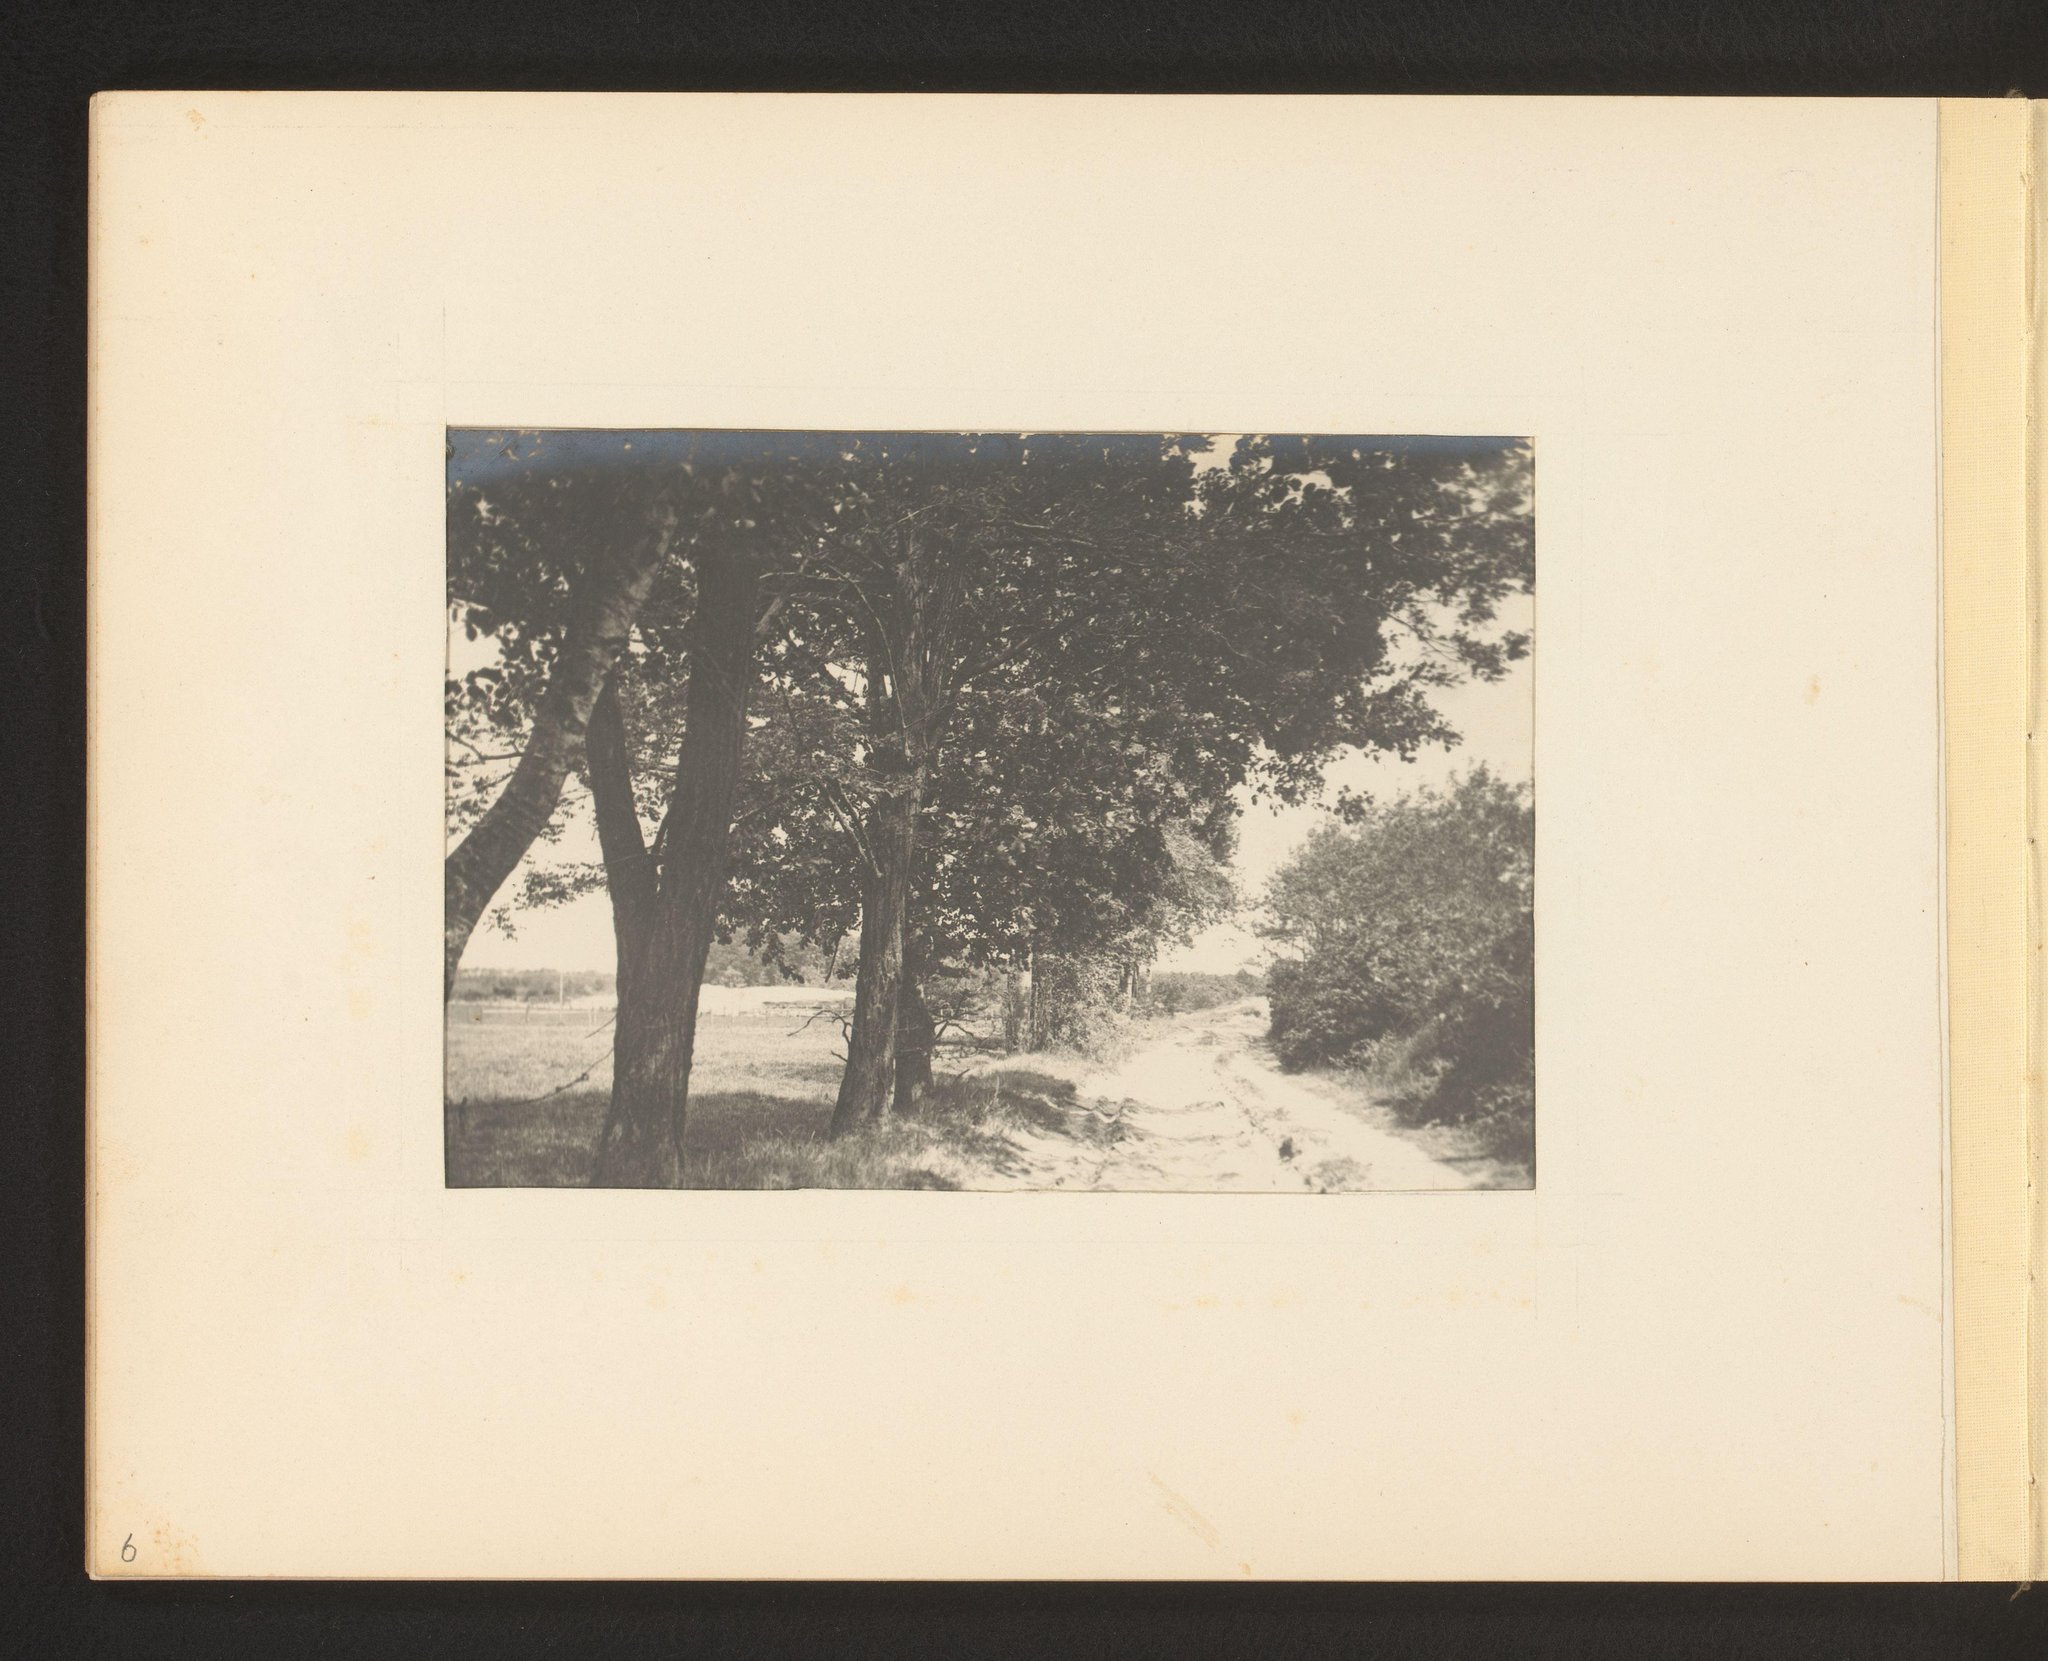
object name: photograph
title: Gezicht op een pad langs weilanden en een rij bomen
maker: Anonymous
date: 1900-1930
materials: photographic support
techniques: gelatin silver print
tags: trees, meadow, pasture, road, path